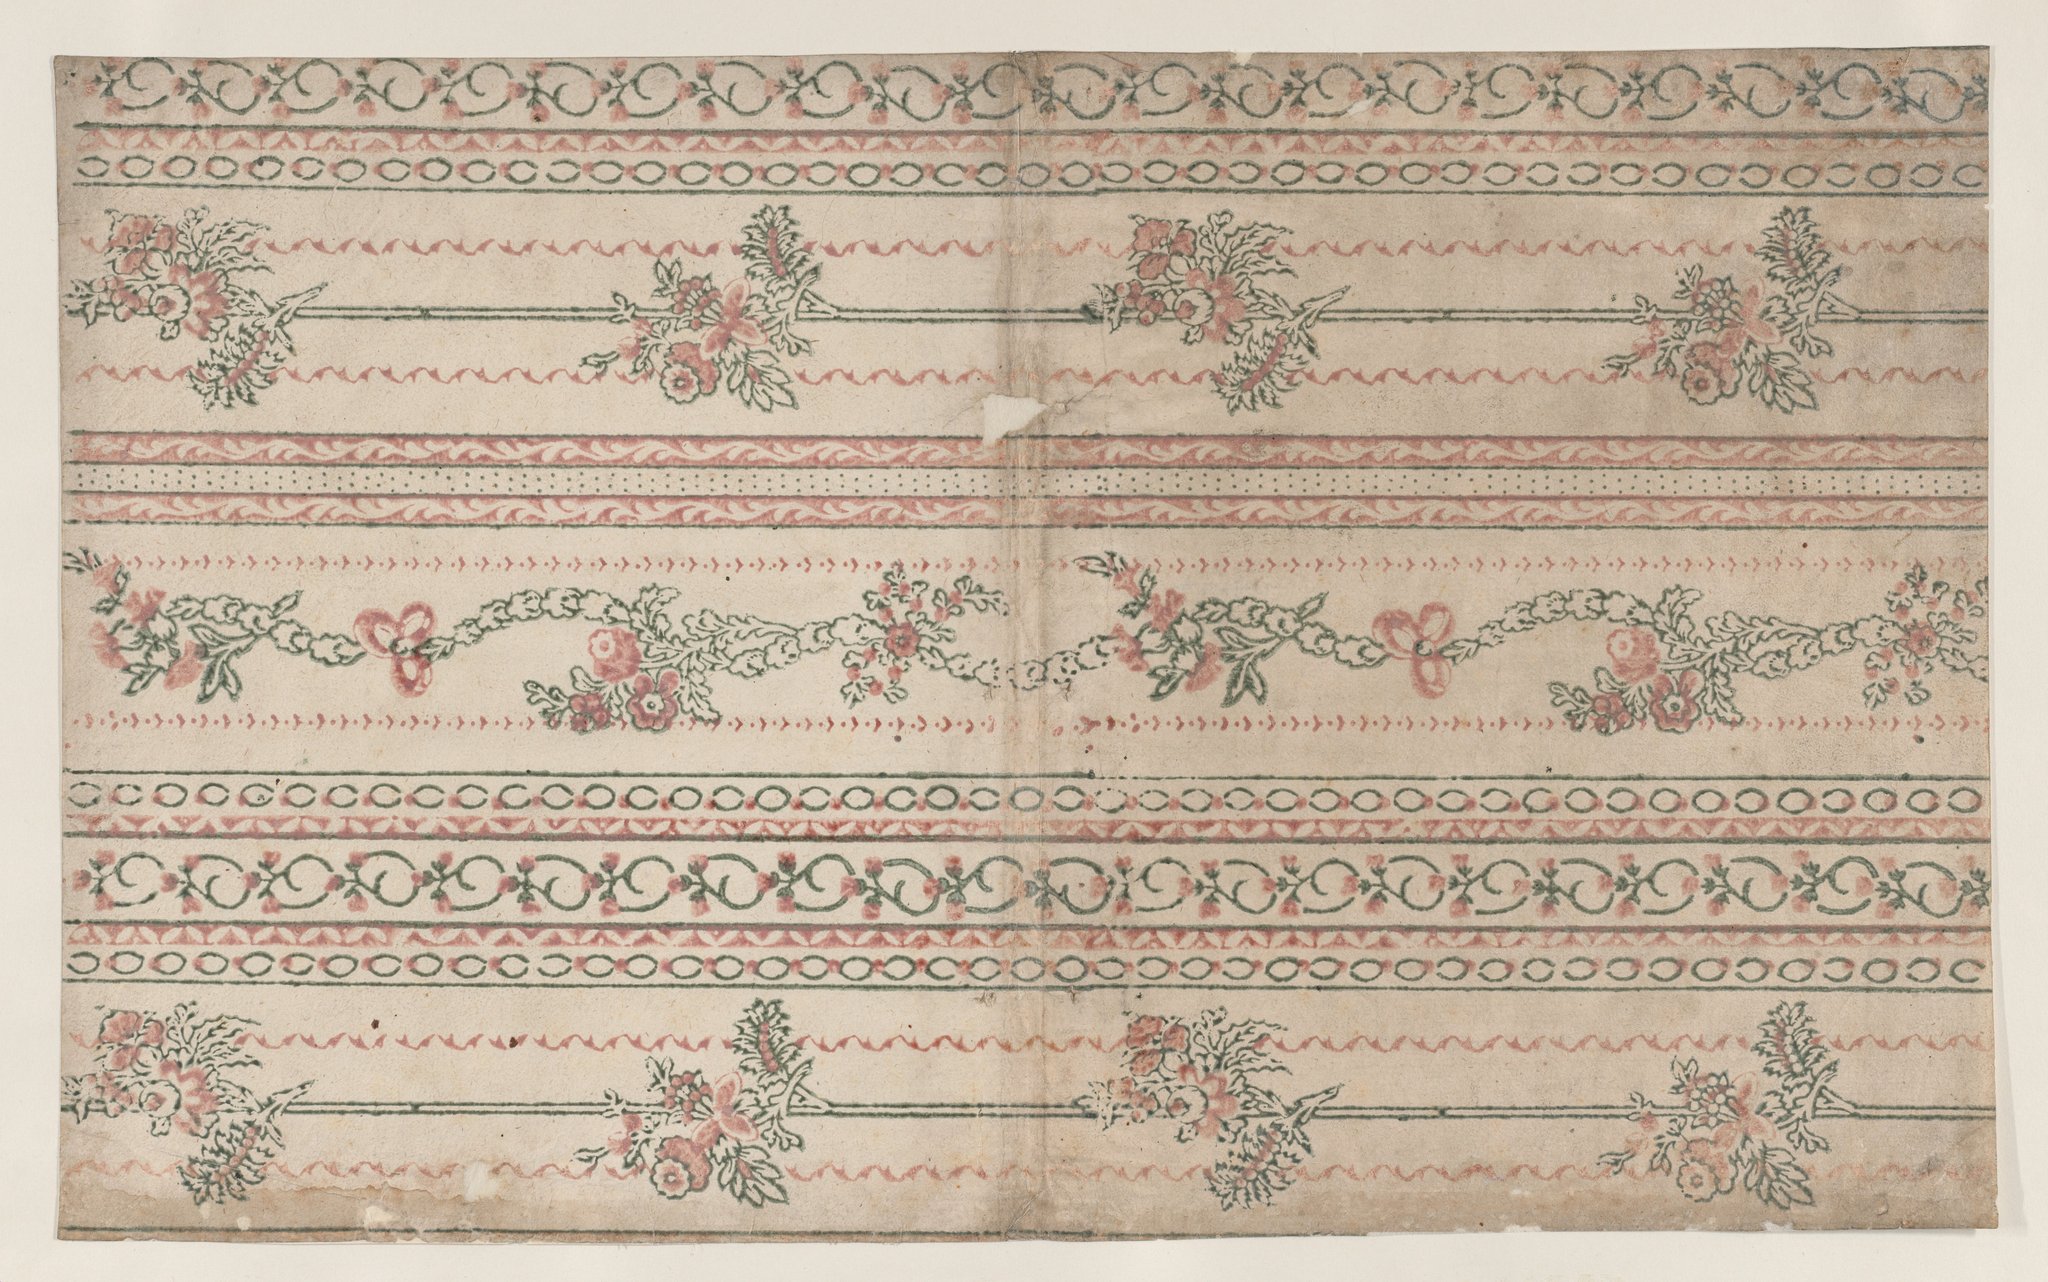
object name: print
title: Sheet with garland designs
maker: Anonymous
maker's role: artist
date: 1801-1900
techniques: relief print